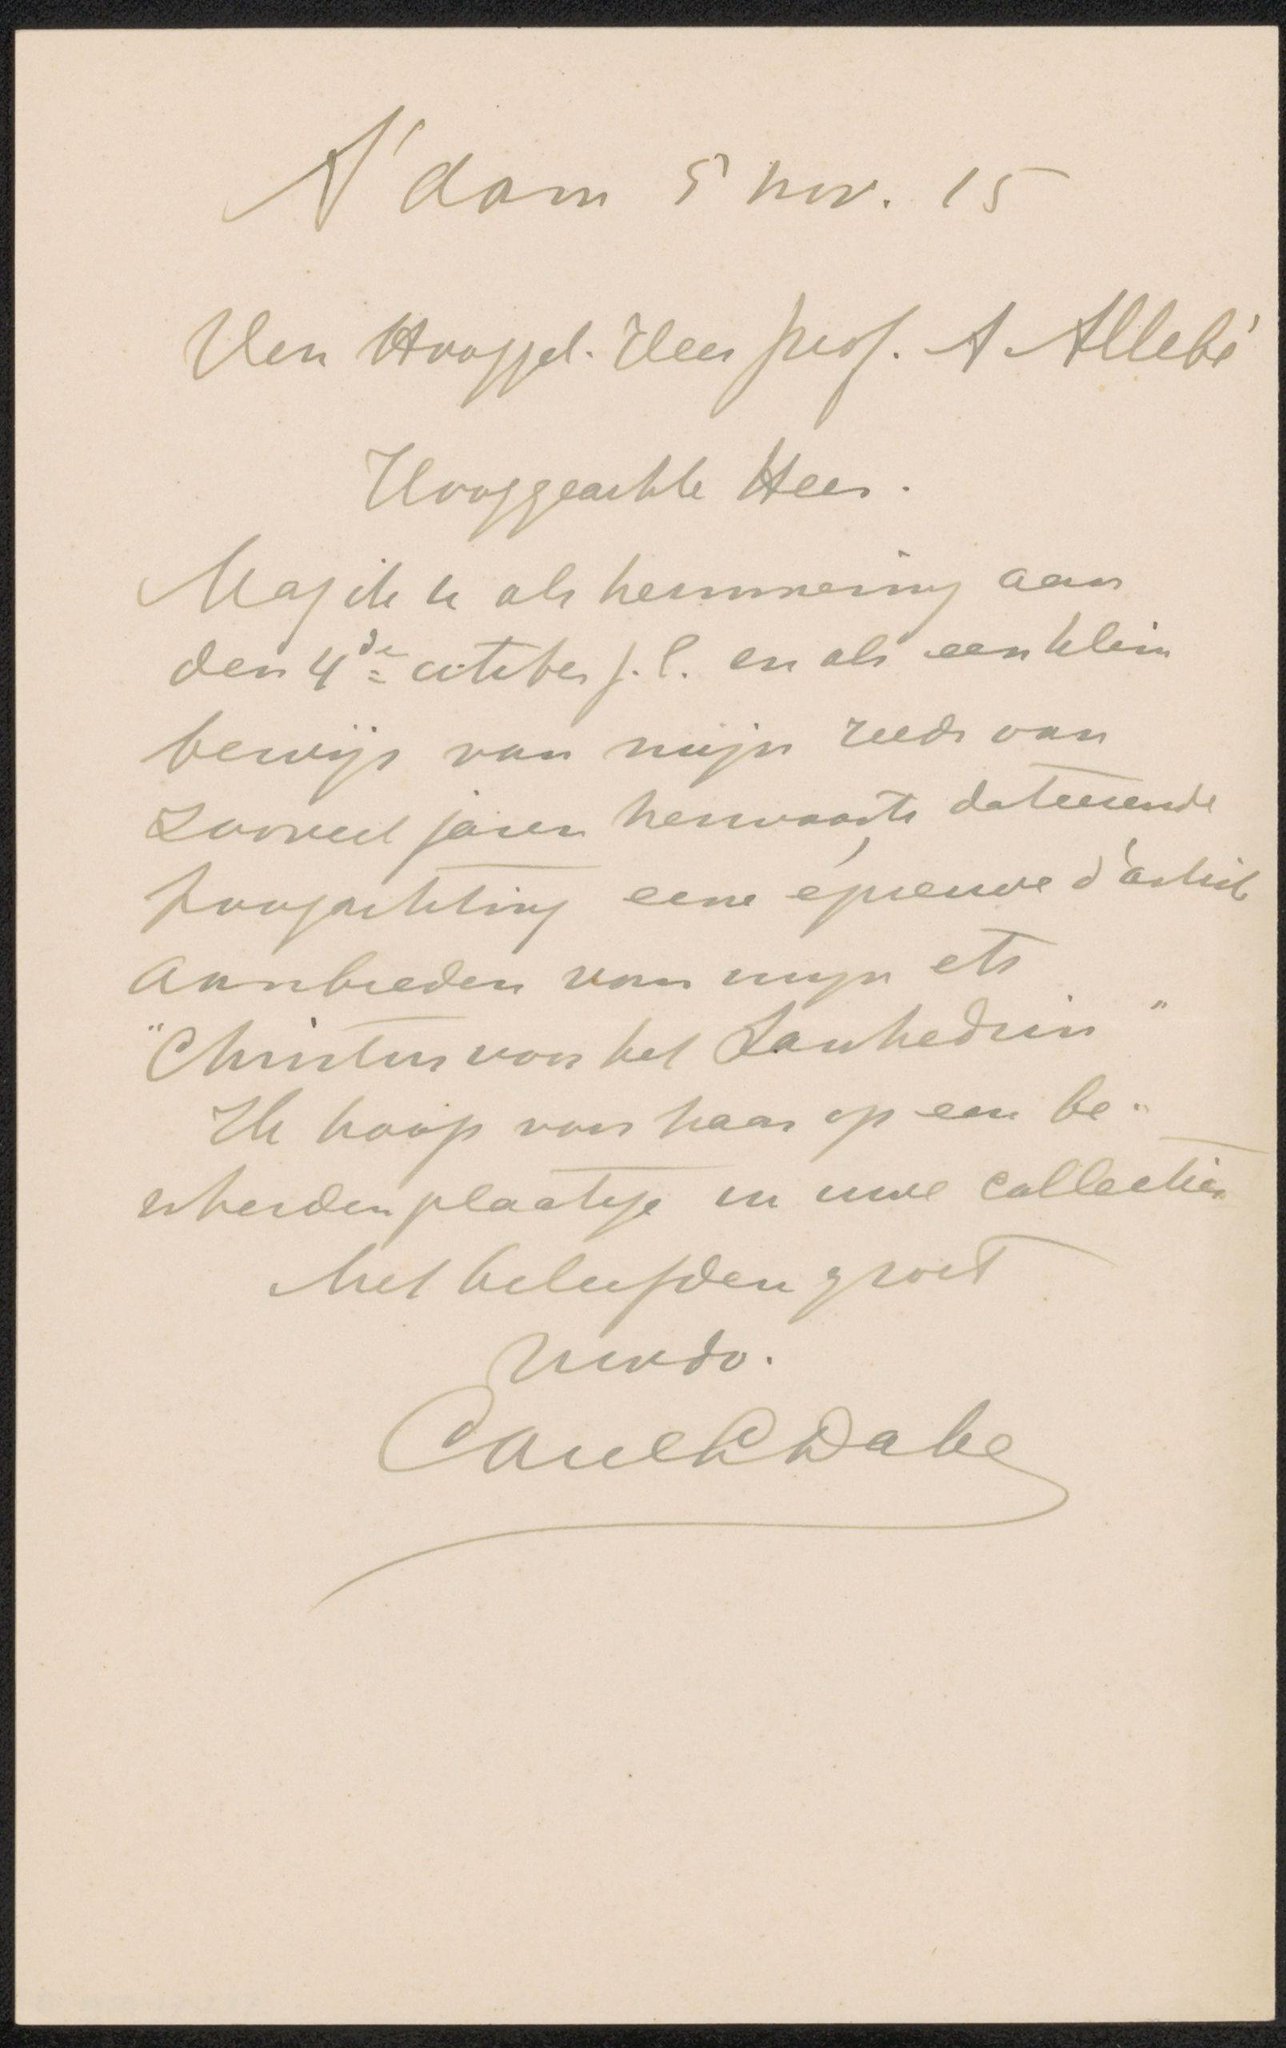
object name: letter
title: Brief aan August Allebé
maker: carel lodewijk dake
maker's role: draughtsman, painter, print maker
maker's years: 1857-1918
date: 1915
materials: ink, paper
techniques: pen, writing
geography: amsterdam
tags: amsterdam, print maker, draughtsman, august allebé, the graphic arts